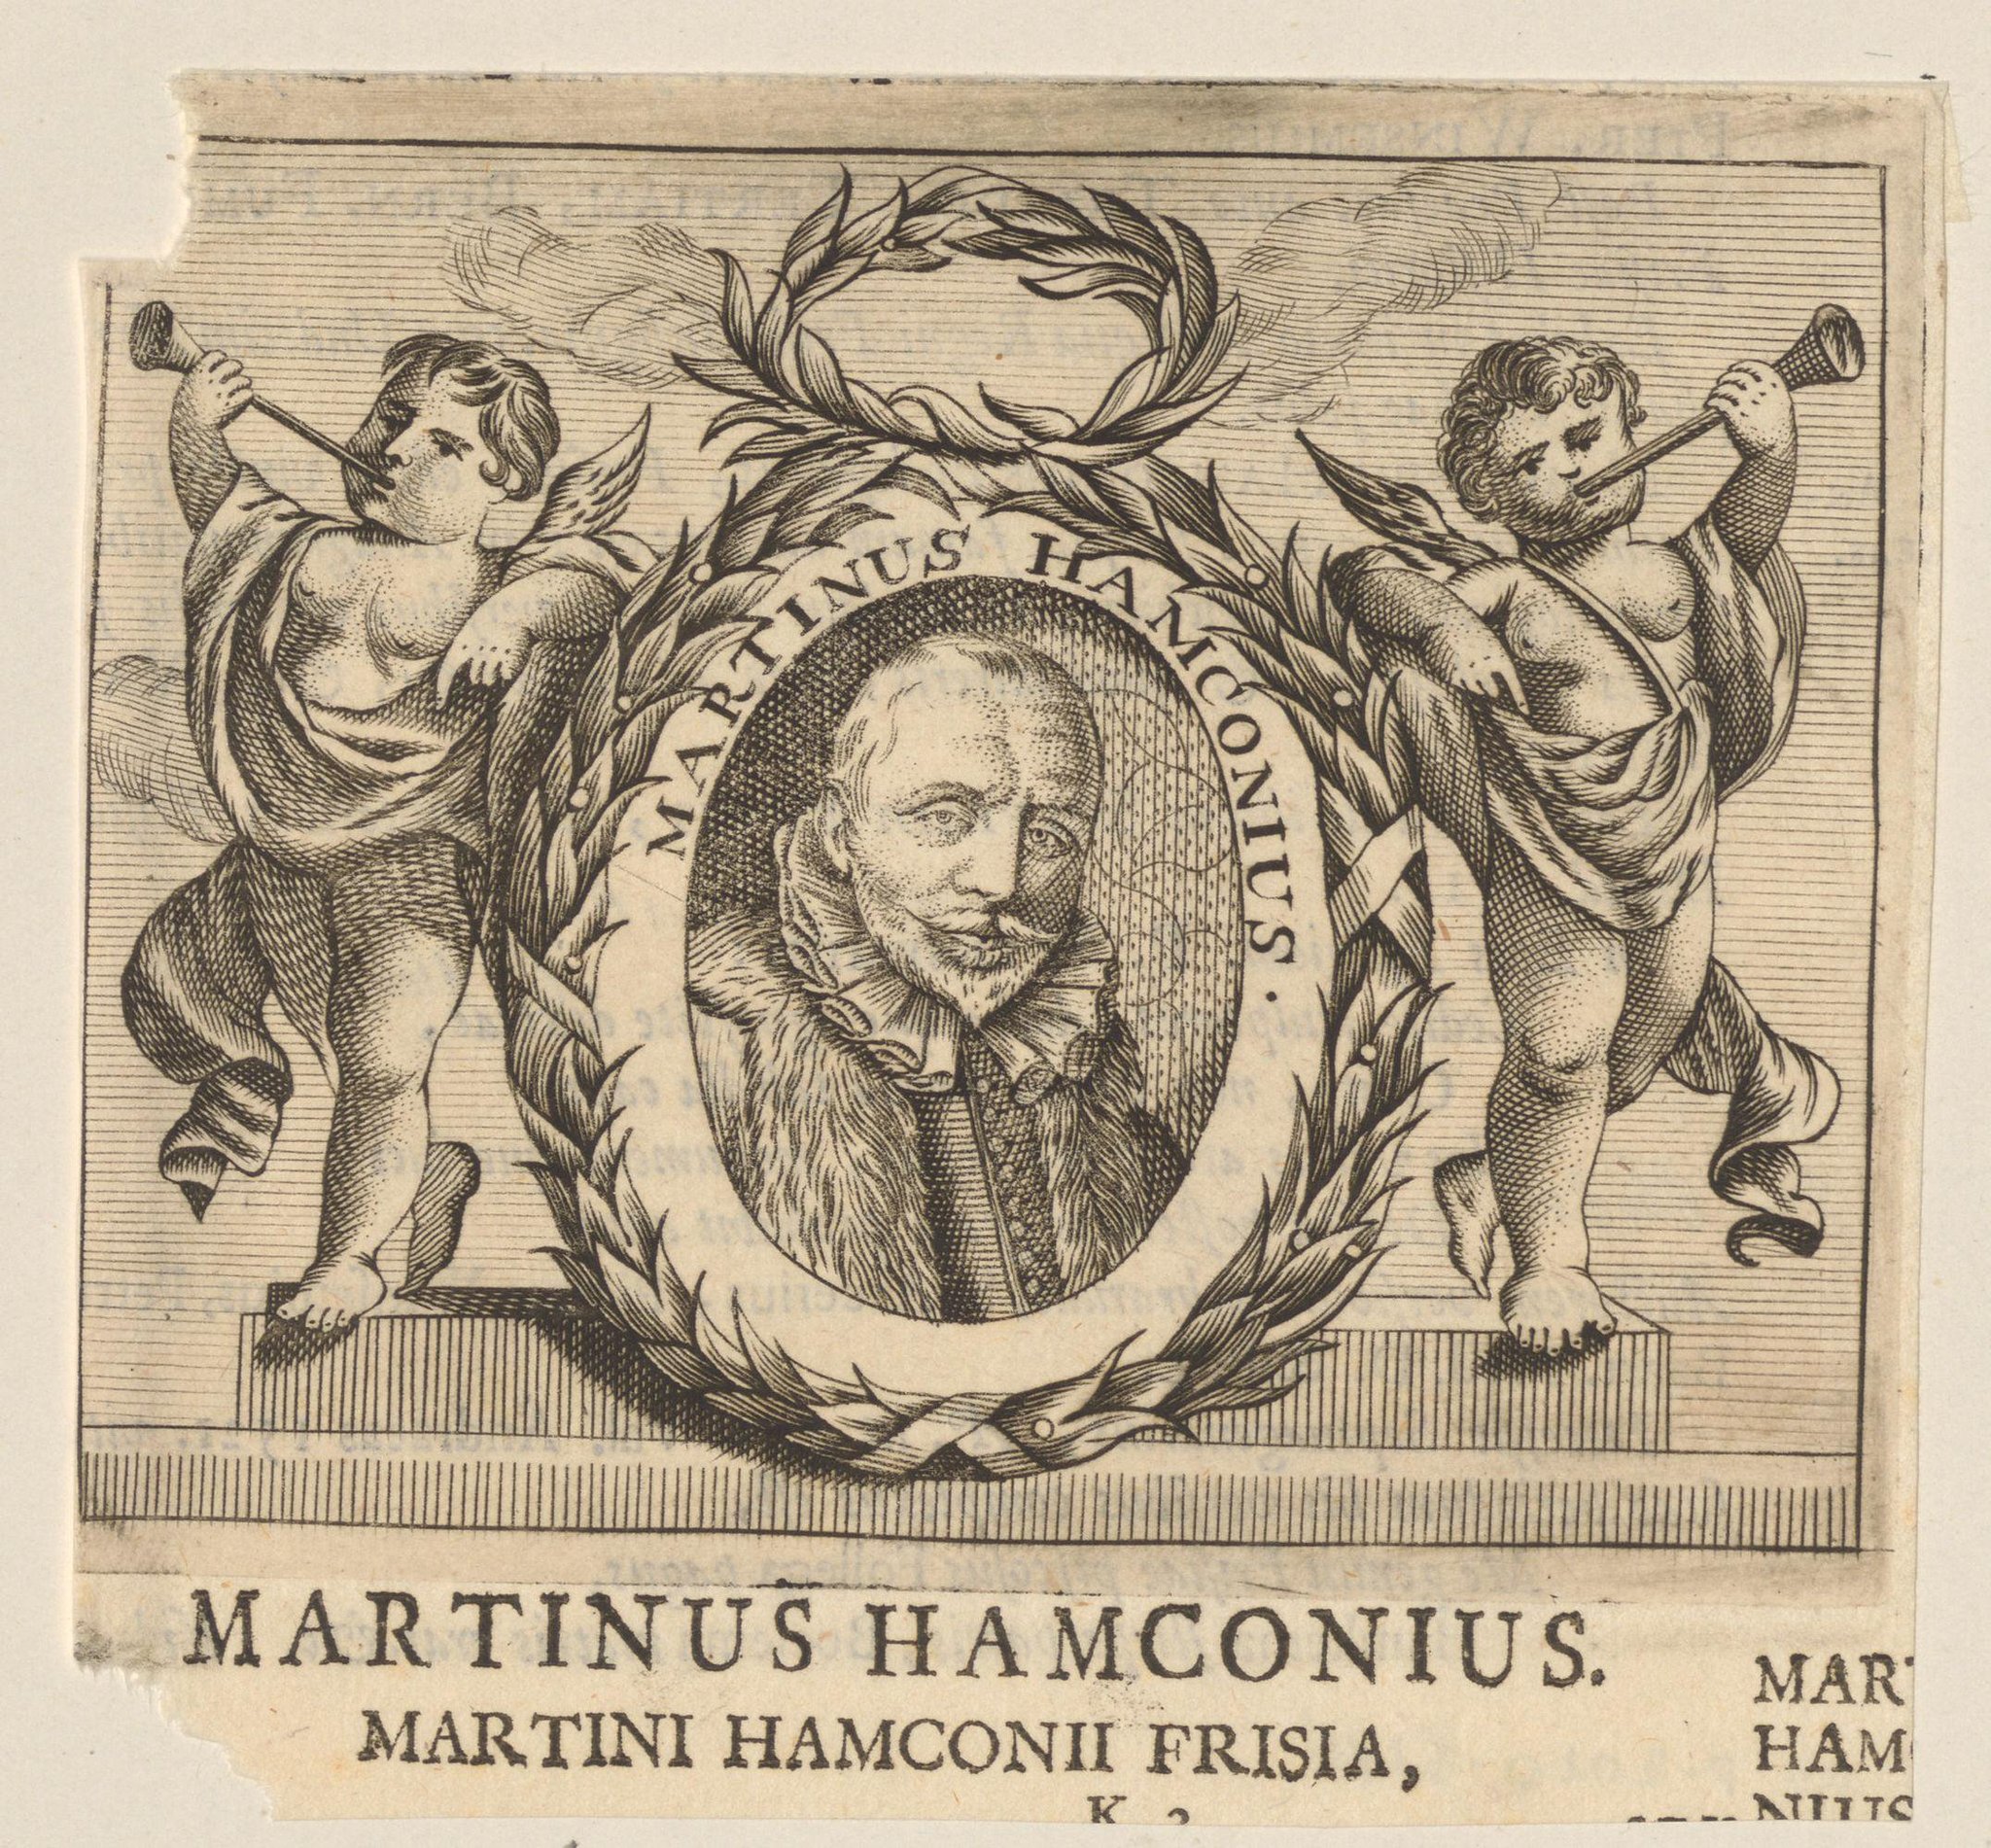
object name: book illustration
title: Portret van Maarten Hamkema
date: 1701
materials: paper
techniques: engraving, letterpress printing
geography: leiden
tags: honouring the artist with laurel wreath, historical persons, portrait of a writer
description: Prent uit: Pars, Adriaan. Index Batavicus, of naamrol van de Batavise en Hollandse schrijvers (...). Leiden: Abraham de Swart, 1701, p. 77.